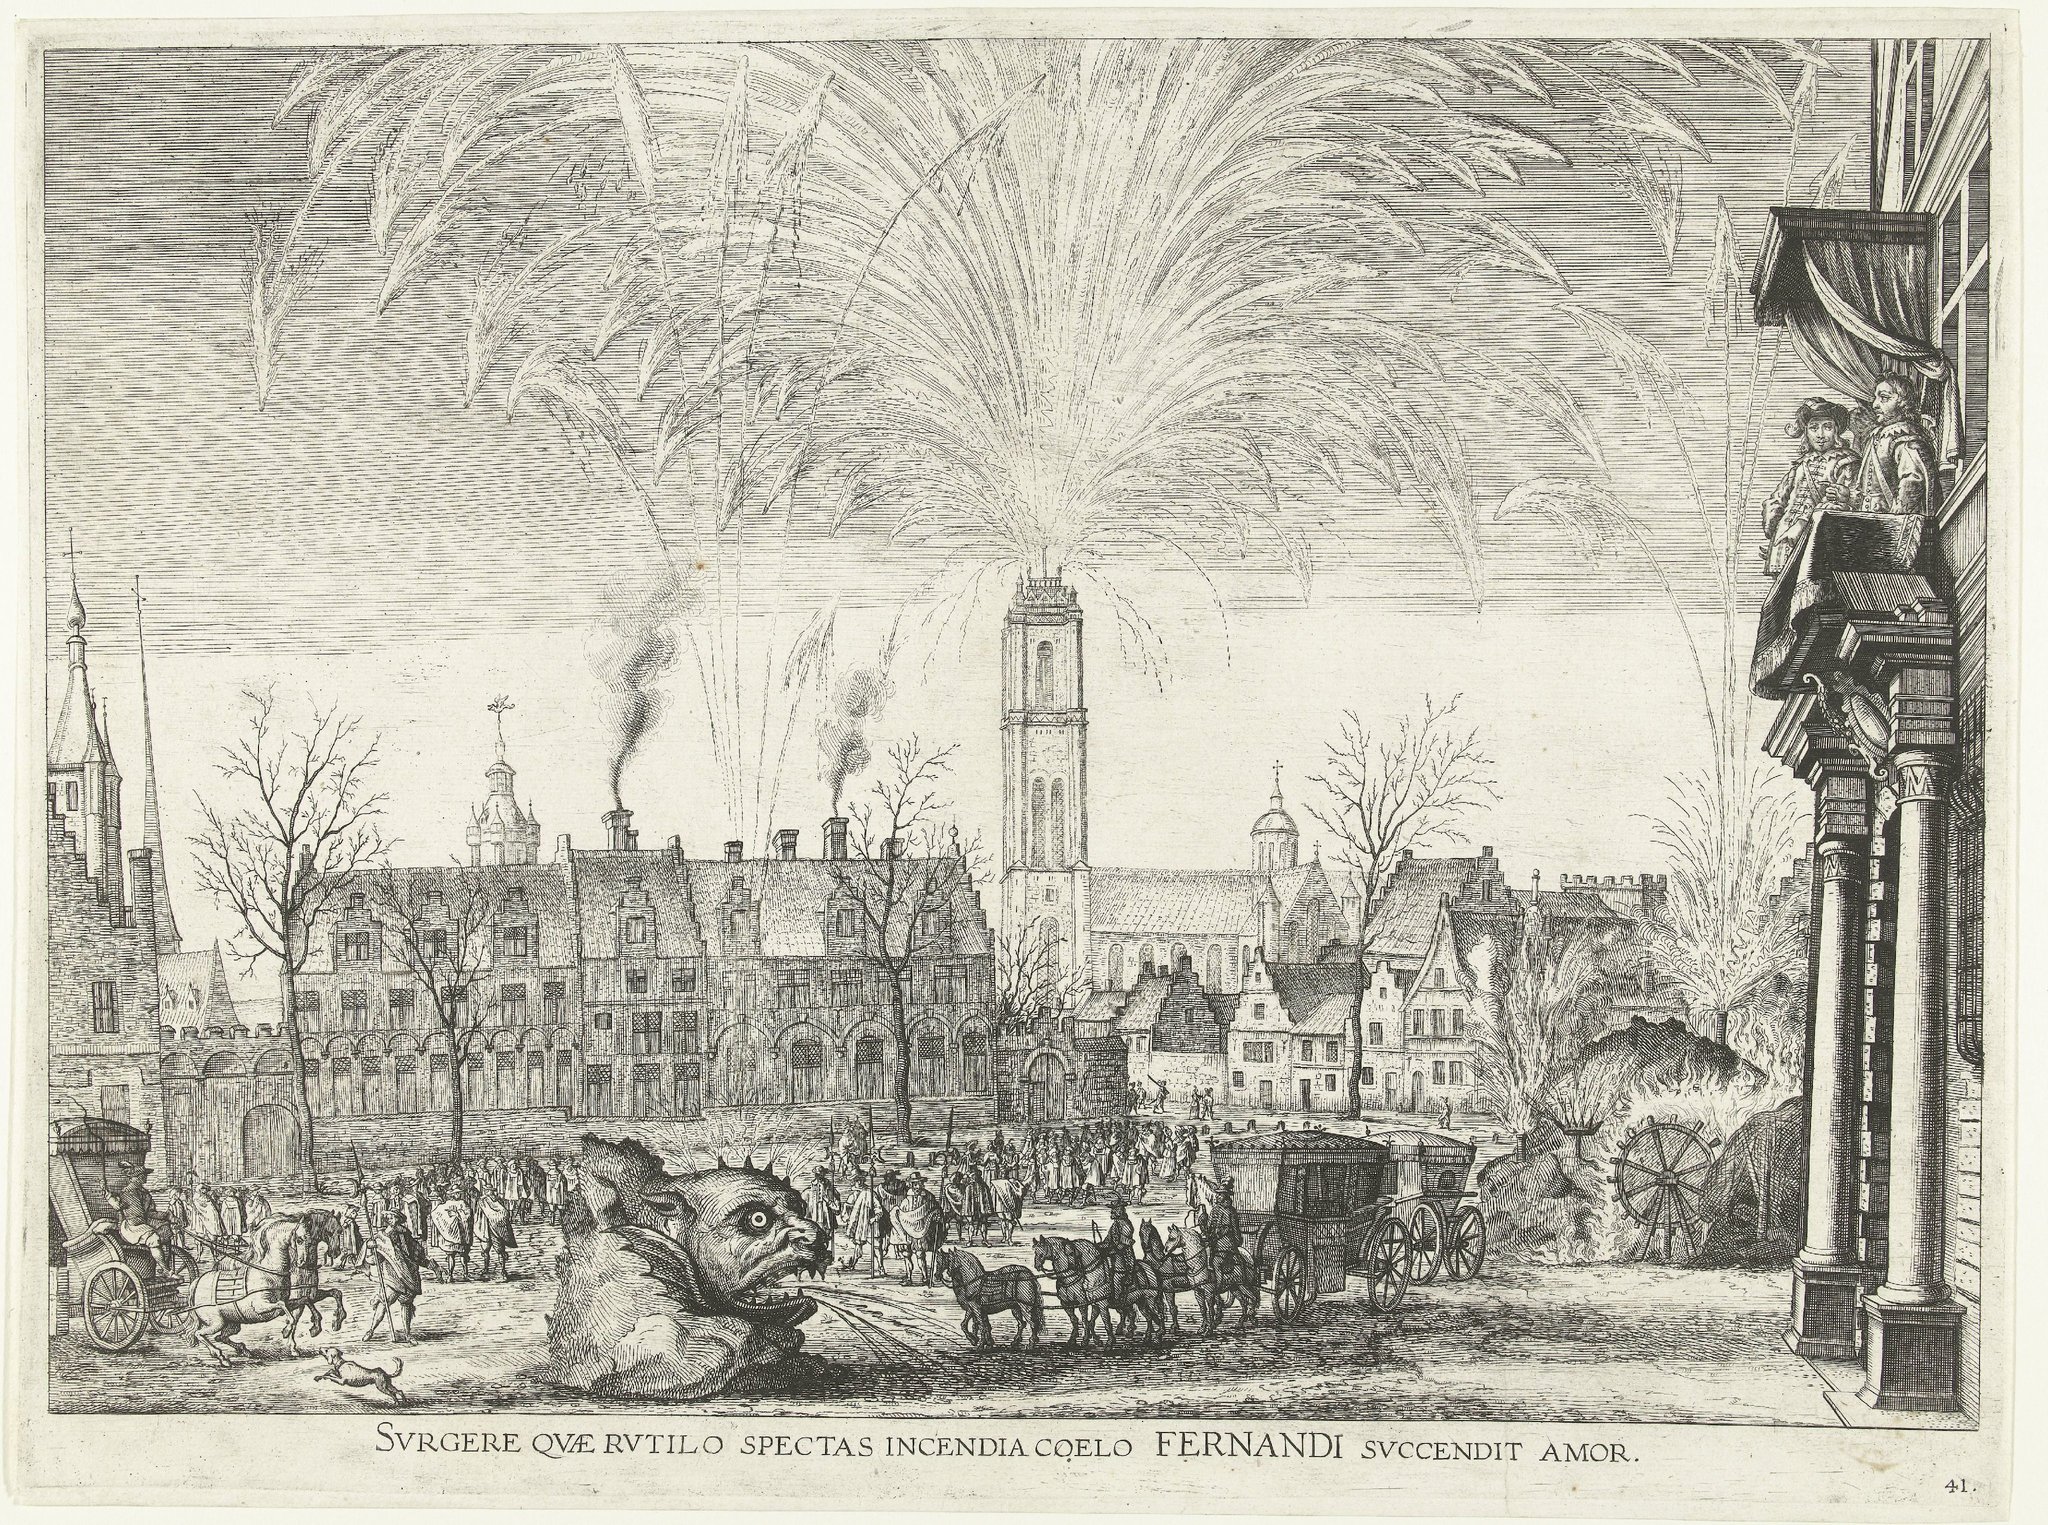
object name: print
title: Ignium nocturnorum in Hippodromo & turri imago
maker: Anonymous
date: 1635-1636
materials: paper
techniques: etching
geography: southern netherlands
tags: brussels, landvoogd der zuidelijke nederlanden ferdinand van oostenrijk, triumphal entry and public reception, pageant, 'entrée solennelle', 'joyeuse entrée', festivities (+ illumination, fire-works ~ festive activities), ghent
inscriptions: collector's mark: Lugt 240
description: Het vuurwerk in de stad afgestoken vanaf een plein en vanaf de Sint-Bavokerk, rechts kijkt Ferdinand toe vanaf een balkon. Op het plein paarden met rijtuigen en een monsterkop die vuur spuwt. Blad nr. 41 in een geheel van 42 platen die de uitgave van de beschrijving van de intocht van de Kardinaal Infant Ferdinand van Oostenrijk te Gent op 28 januari 1635 als de nieuwe landvoogd voor de Spaanse Nederlanden illustreren.